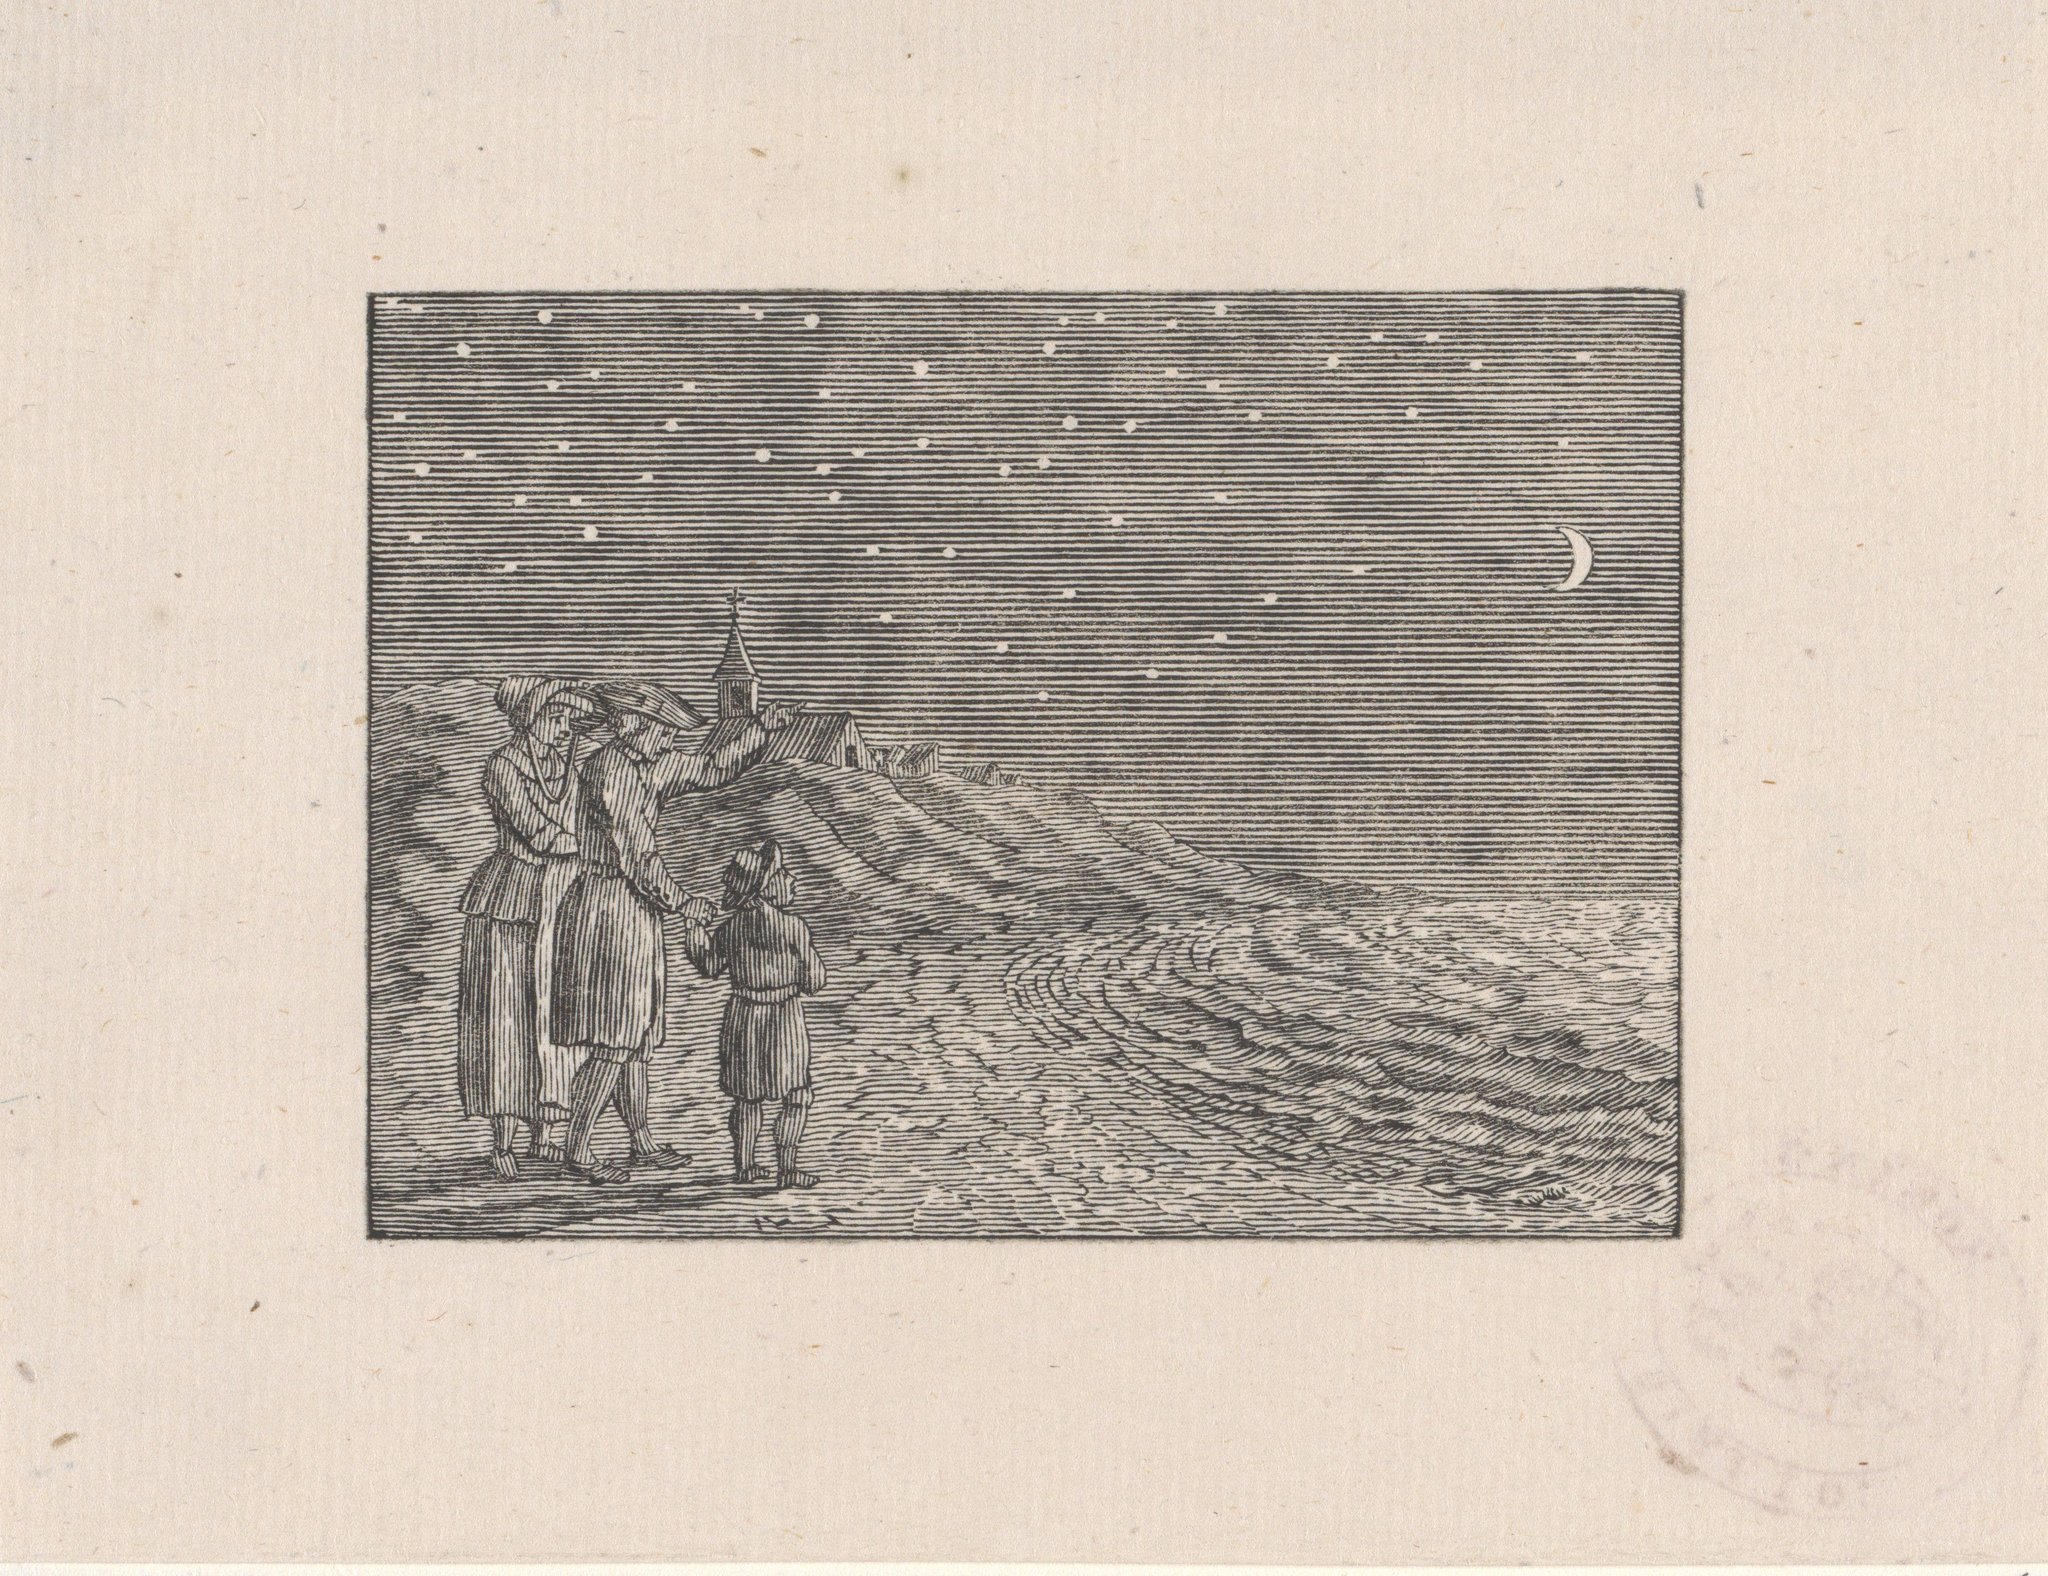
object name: print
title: Man en een vrouw leren een jongen over de sterren en de maan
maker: hendrik numan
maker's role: draughtsman, print maker, publisher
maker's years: 1736-1788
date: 1746-1788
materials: paper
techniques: woodcut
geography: haarlem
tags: boy (child between toddler and youth), stars, education, moon as celestial body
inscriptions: collector's mark: Lugt 240